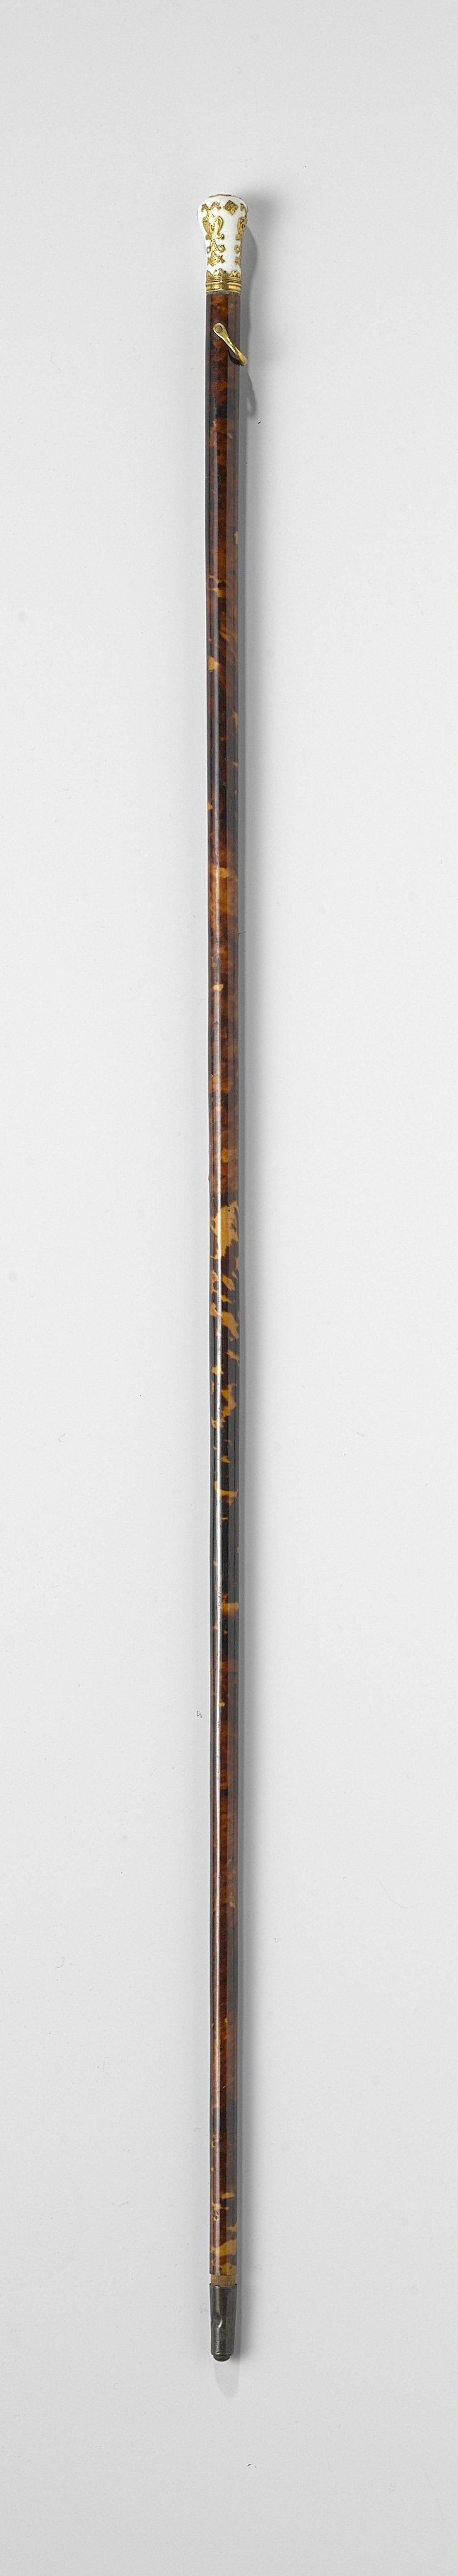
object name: swagger stick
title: Dunne stok (badine) van hout belijmd met schildpad en voorzien van een knop van wit porseleinen, versierd met ornamentjes van bladgoud, gezet in een vergulde rand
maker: Anonymous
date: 1750-1775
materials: brass, gold, porcelain, silver, shell, wood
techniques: cutting, firing, silvering, striking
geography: netherlands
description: Dunne stok (badine) van hout belijmd met schildpad en voorzien van een knop van wit porseleinen, versierd met ornamenten van bladgoud, gezet in een vergulde rand. Met koperen ring.